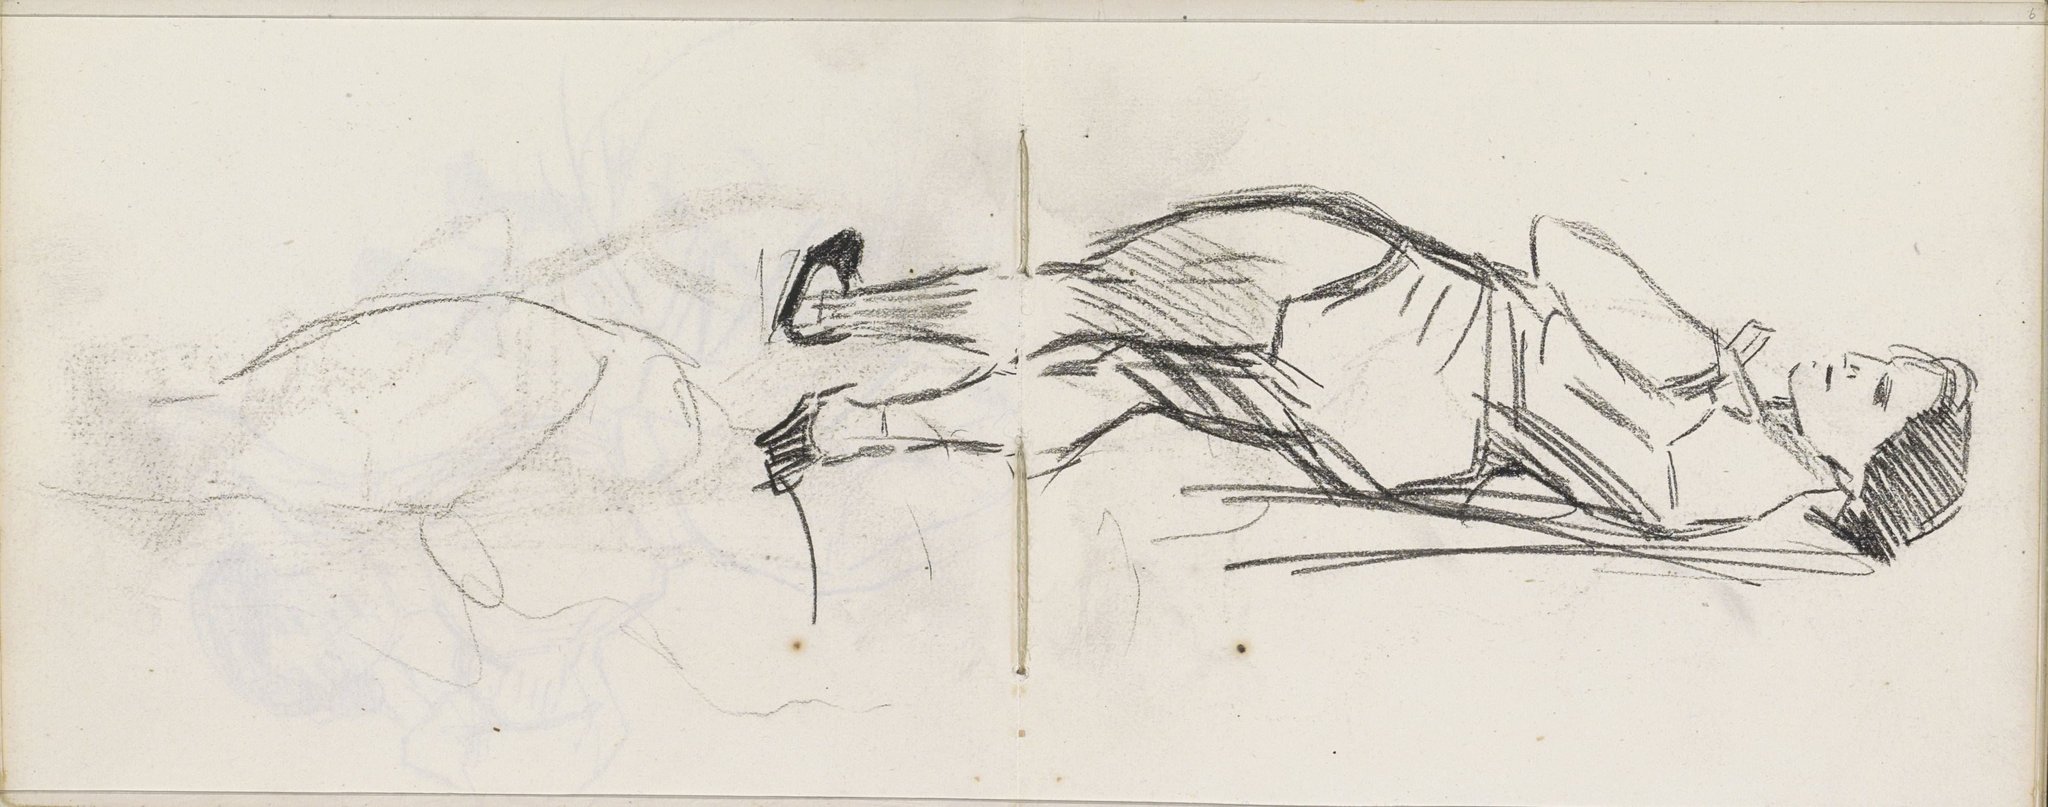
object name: sketchbook leaf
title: Leunende vrouw, op de rug gezien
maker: isaac israels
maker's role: draughtsman, painter, print maker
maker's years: 1865-1934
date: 1875-1934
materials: chalk, paper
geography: the hague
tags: looking over the shoulder - aa - female human figure, performer, artiste (non-work situations), adult woman (+ leaning)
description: Ze kijkt over haar schouder. Mogelijk een variétéartieste. Pagina 5 en pagina 6 uit schetsboek XLIII met 61 pagina's.